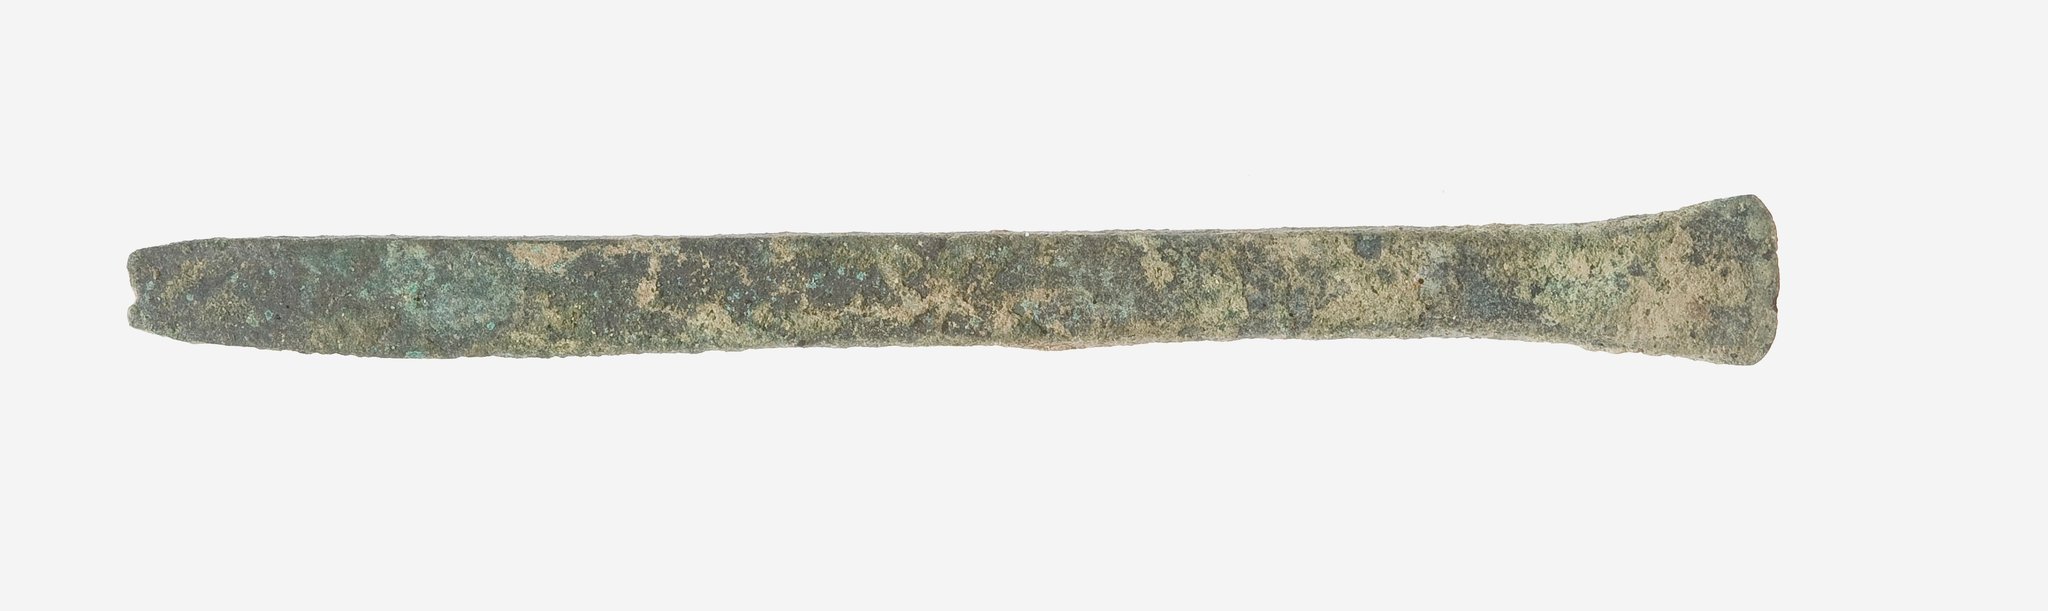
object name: chisel, metalworker's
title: Metalworker's Chisel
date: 1390-1352 BCE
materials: bronze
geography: egypt